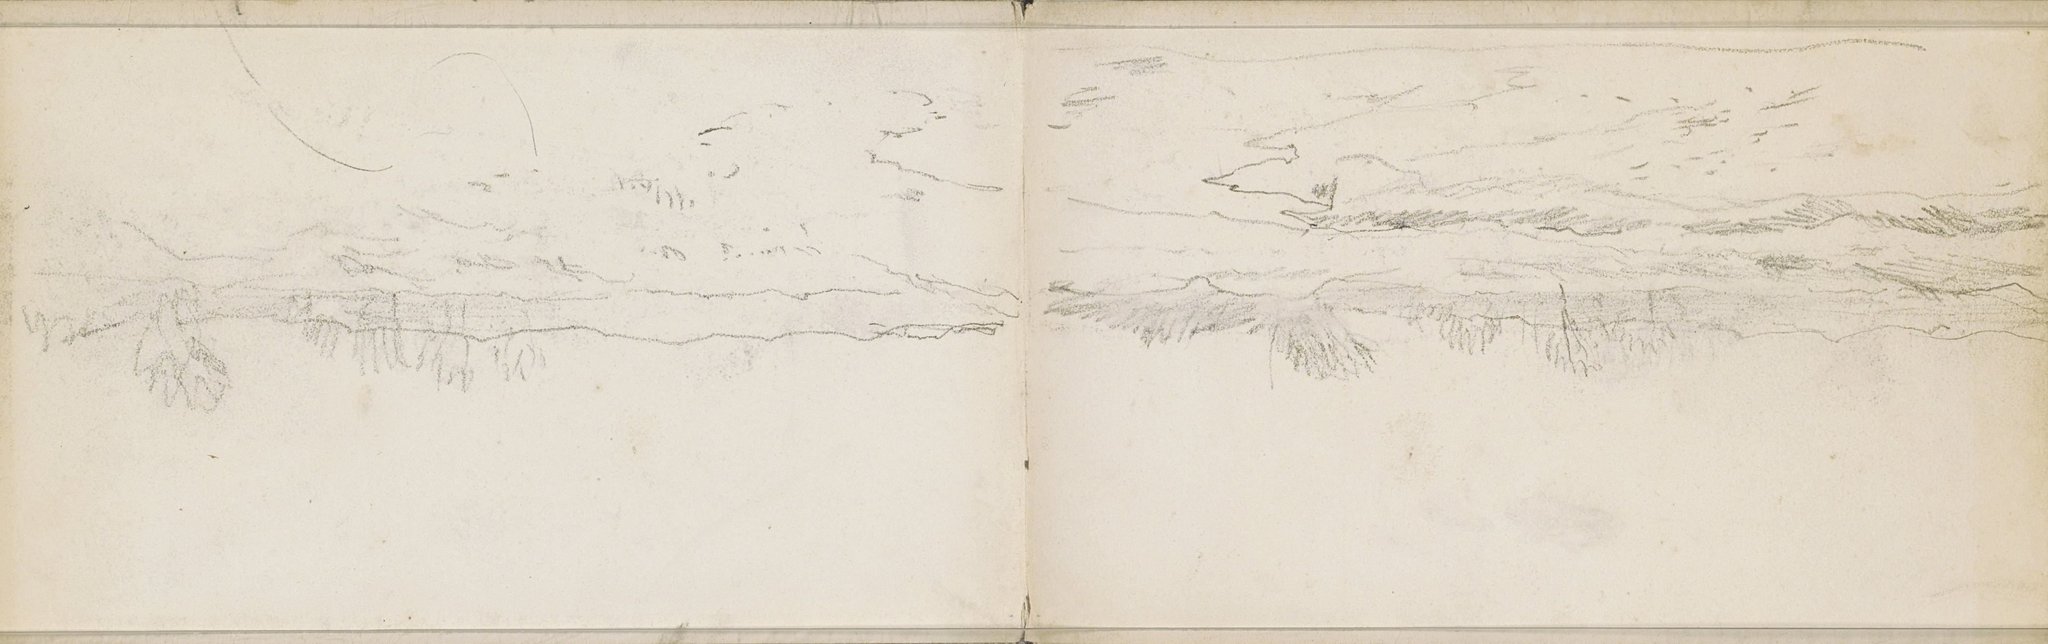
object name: endleaf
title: Landschap met bomen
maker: anton mauve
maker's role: draughtsman, painter, print maker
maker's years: 1838-1888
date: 1848-1888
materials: paper, pencil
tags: landscapes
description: Voorste schutblad en pagina 1 recto uit een schetsboek met 44 bladen.